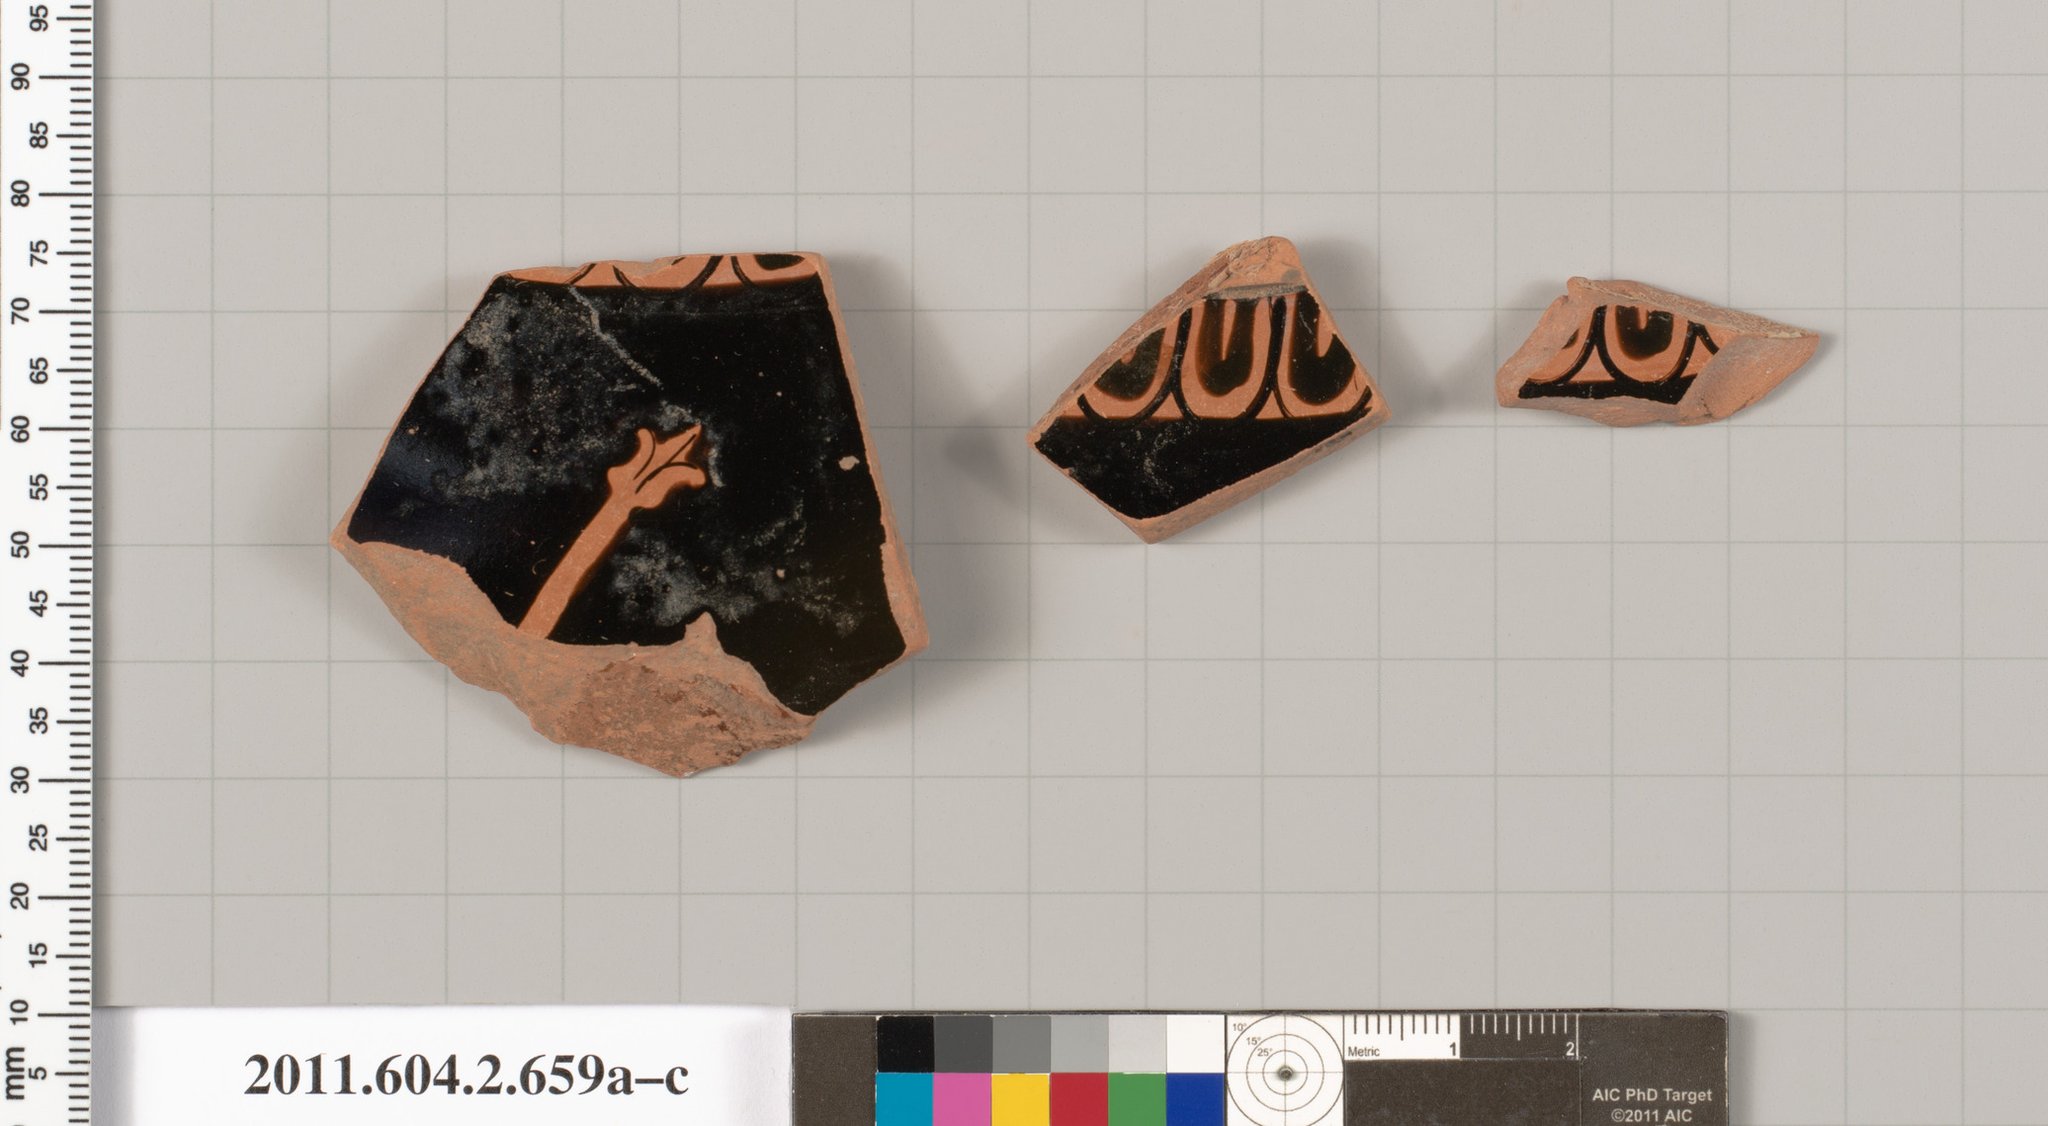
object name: column krater fragment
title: Terracotta fragments of a column-krater (bowl for mixing wine and water)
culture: greek, attic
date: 475-451 BCE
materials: terracotta